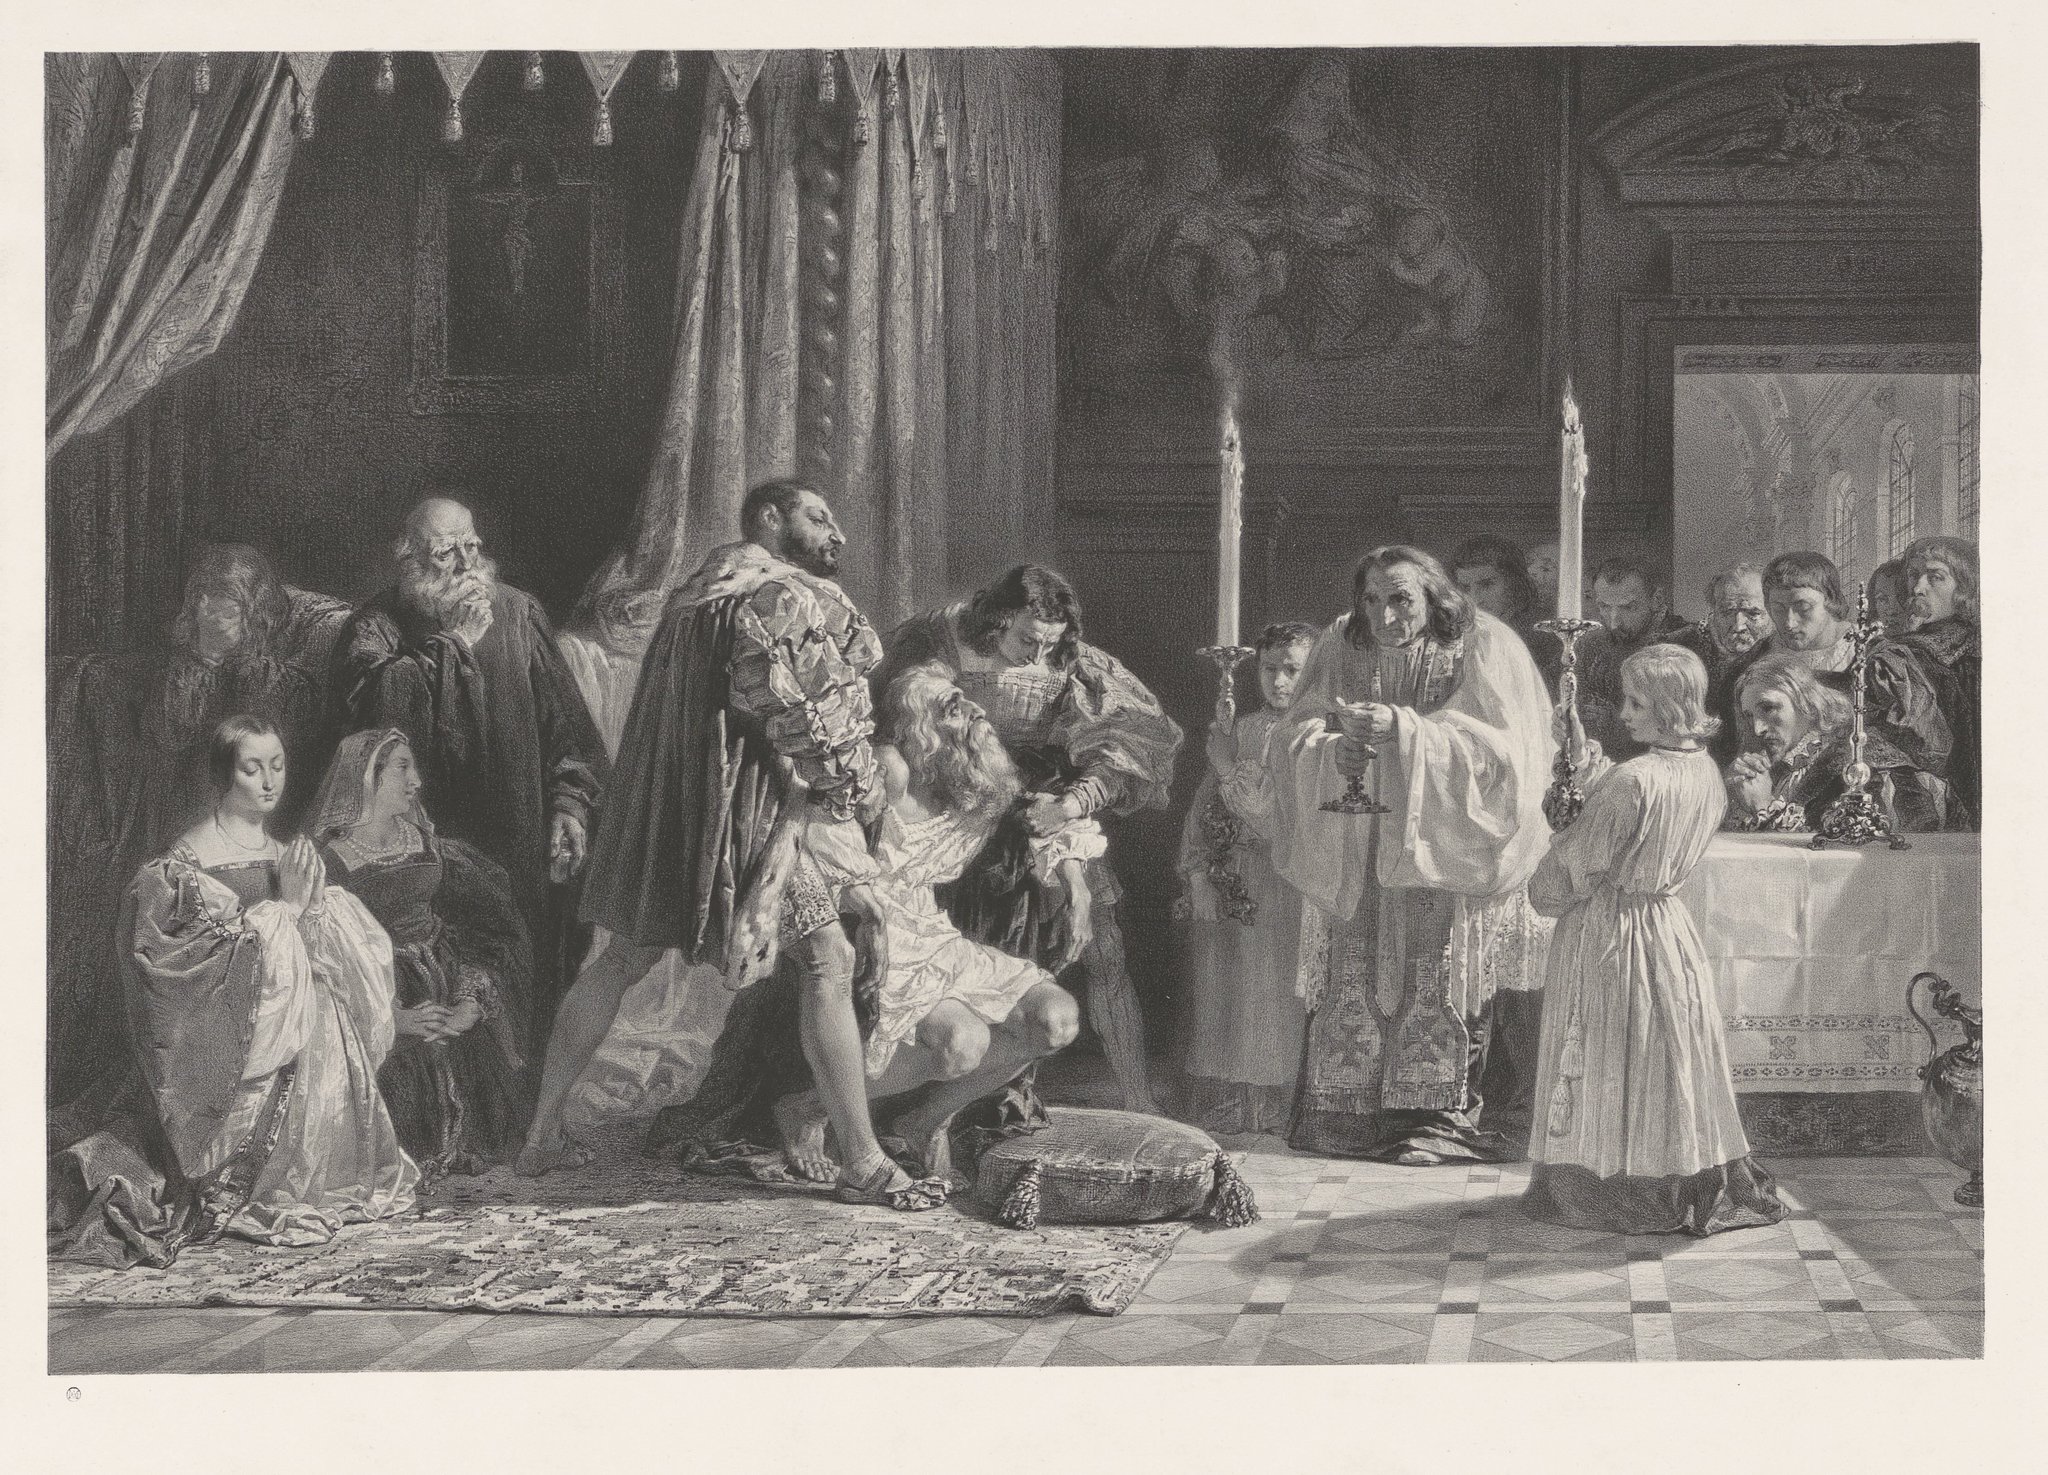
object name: print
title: Dood van Leonardo da Vinci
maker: adolphe mouilleron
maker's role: draughtsman, print maker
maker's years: 1820-1881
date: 1835-1881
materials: paper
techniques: lithograph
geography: paris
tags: painter in non-work situation, death in old age, king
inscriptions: collector's mark: Lugt 2228, collector's mark: Lugt 4788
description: De stervende schilder wordt ondersteund door koning Frans I. Hij tracht de schilder te laten knielen voor een priester die met het laatste sacrament nadert.